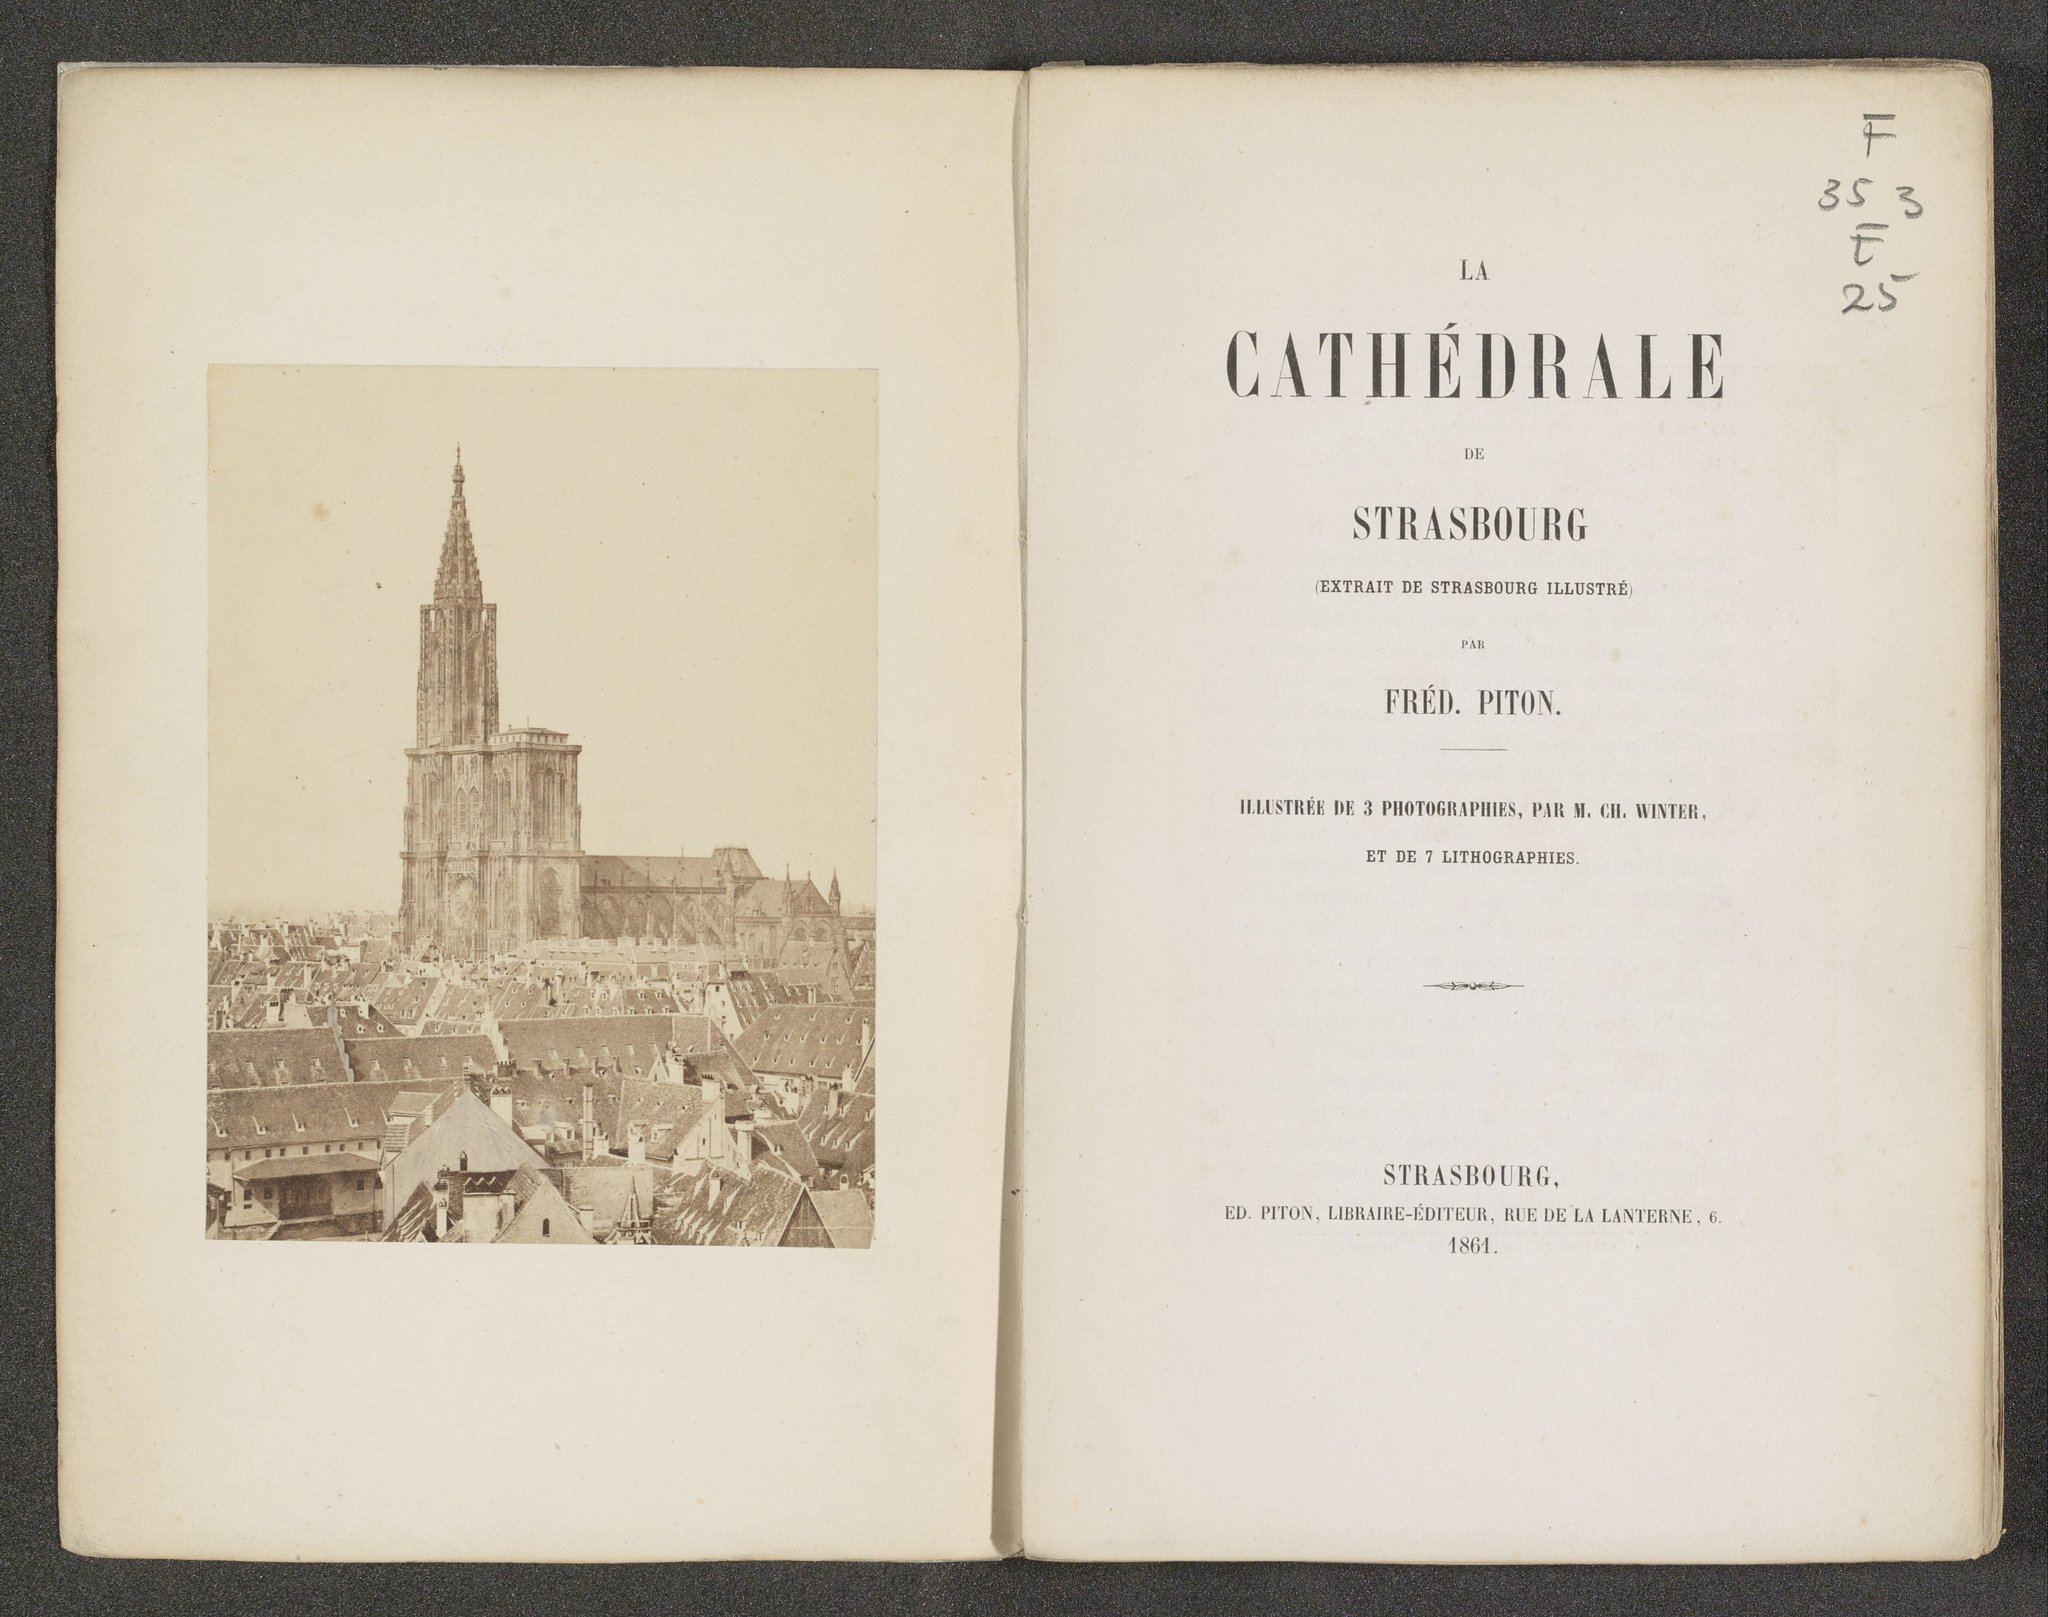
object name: photograph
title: Gezicht op de kathedraal van Straatsburg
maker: charles david winter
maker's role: fotograaf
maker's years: 1821-1904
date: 1851-1861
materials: photographic support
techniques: albumen print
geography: straatsburg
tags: church (exterior)